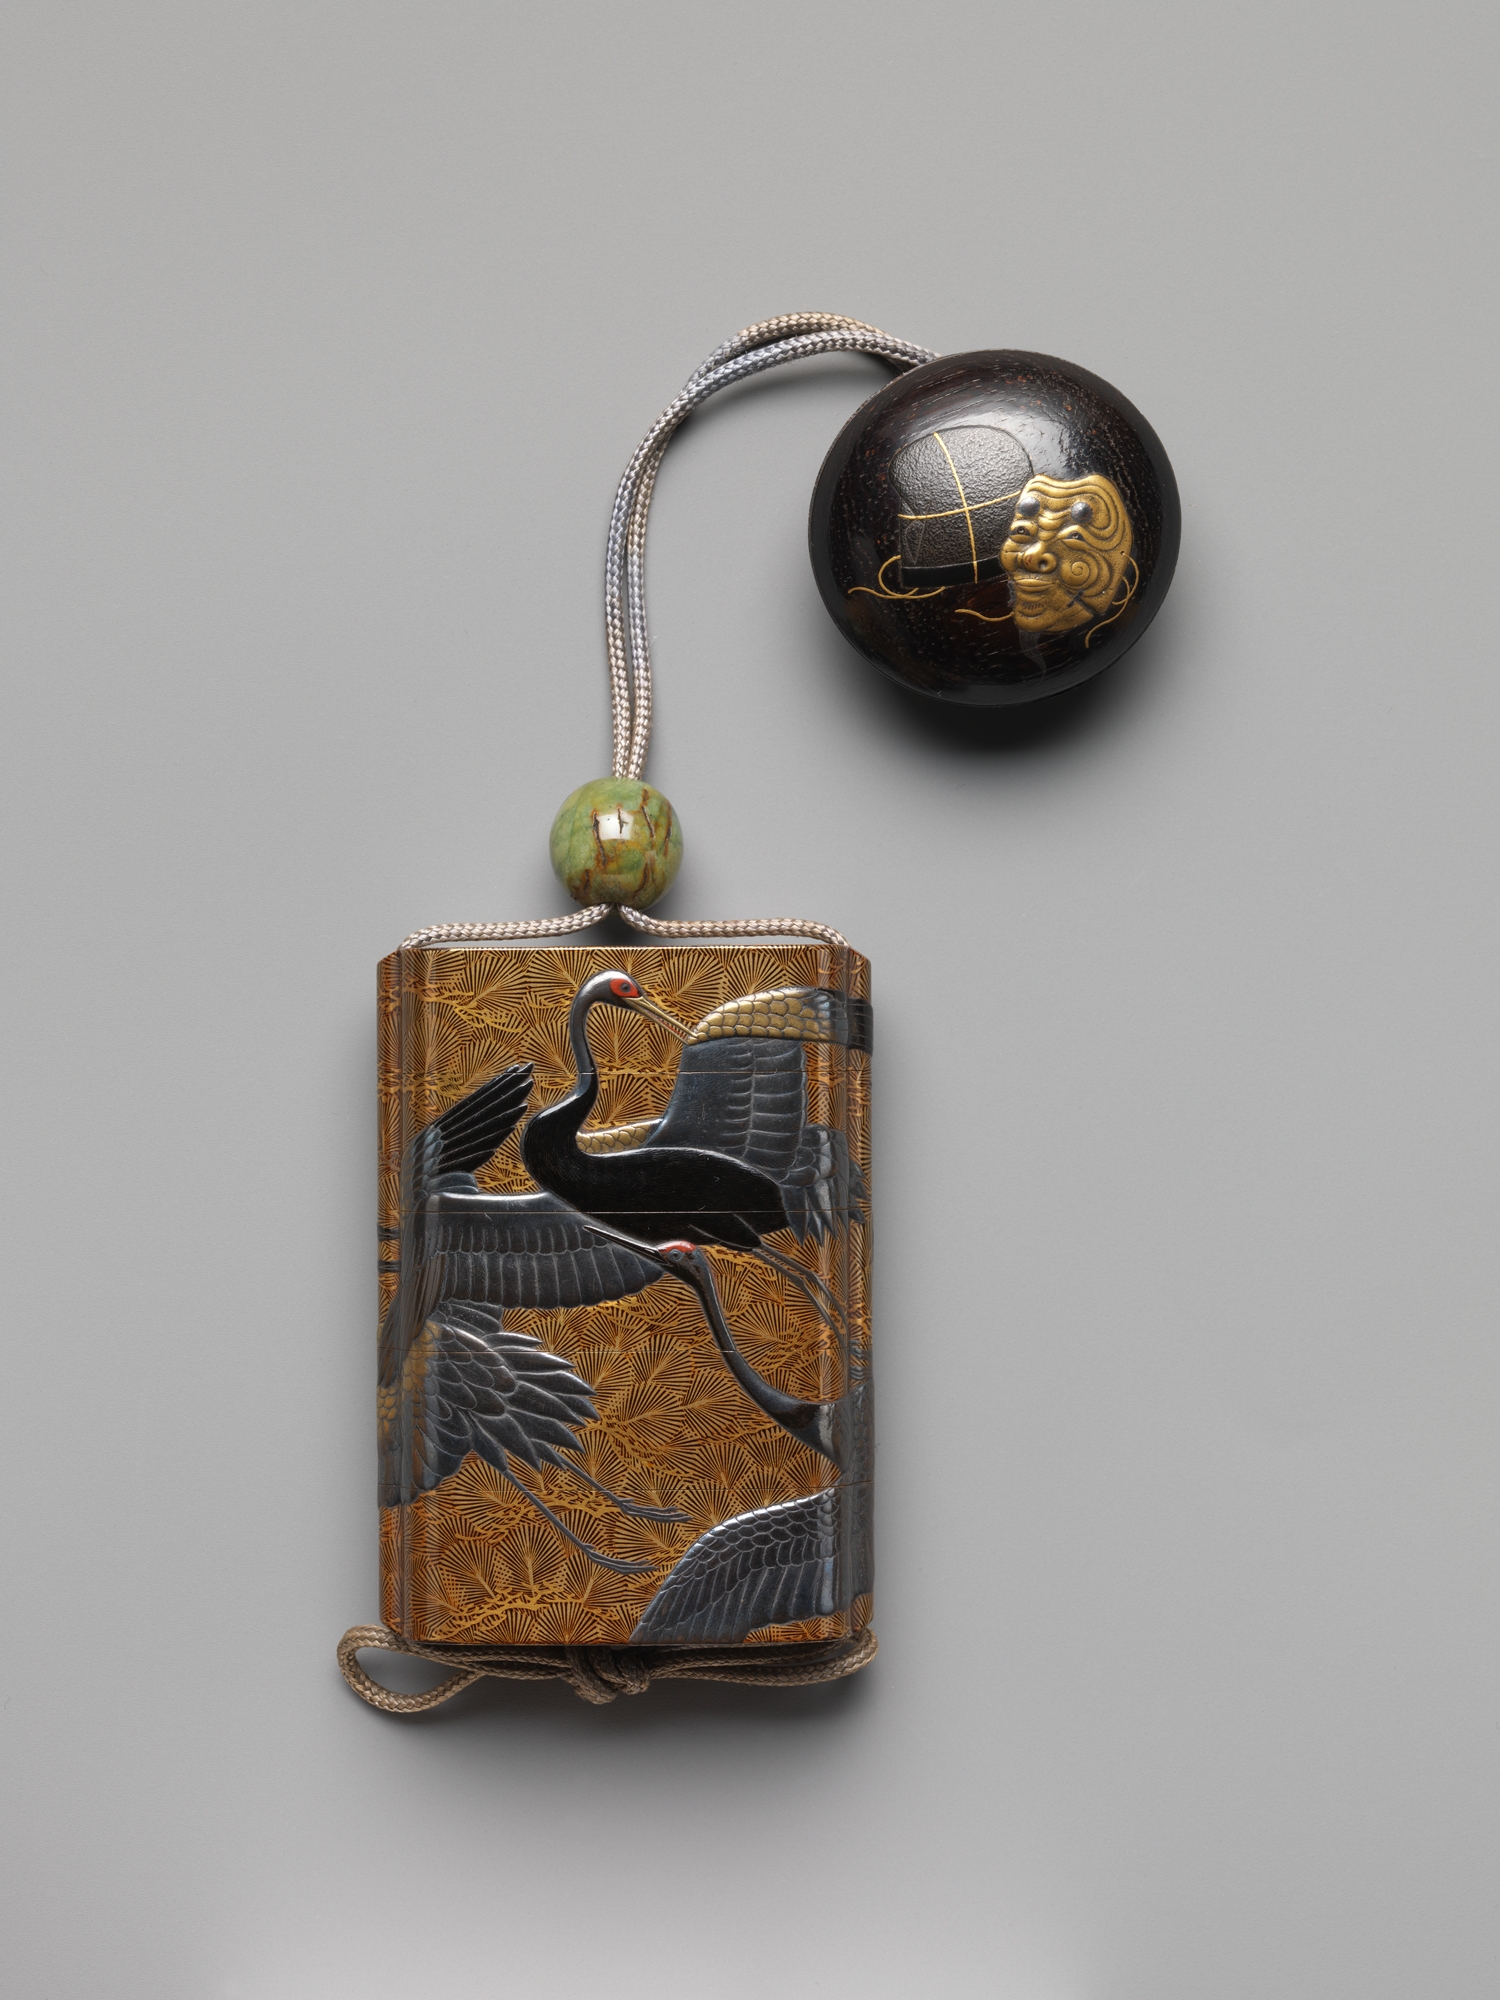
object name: inrō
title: Inrō with Cranes and Pines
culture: japanese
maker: koma kyūhaku v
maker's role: artist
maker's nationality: japanese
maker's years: -1794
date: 1701-1800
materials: gold, jade, lacquer, silver, wood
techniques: hiramakie, maki-e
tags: cranes